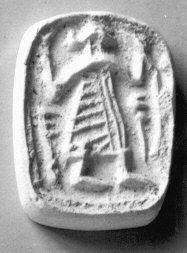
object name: stamp seal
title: Rectangular stamp seal with gable-head handle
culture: hittite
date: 1500-1201 BCE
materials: stone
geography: anatolia